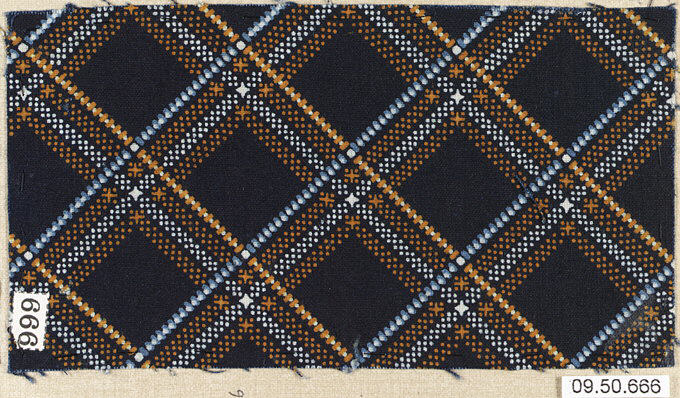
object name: piece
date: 1801-1900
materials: cotton